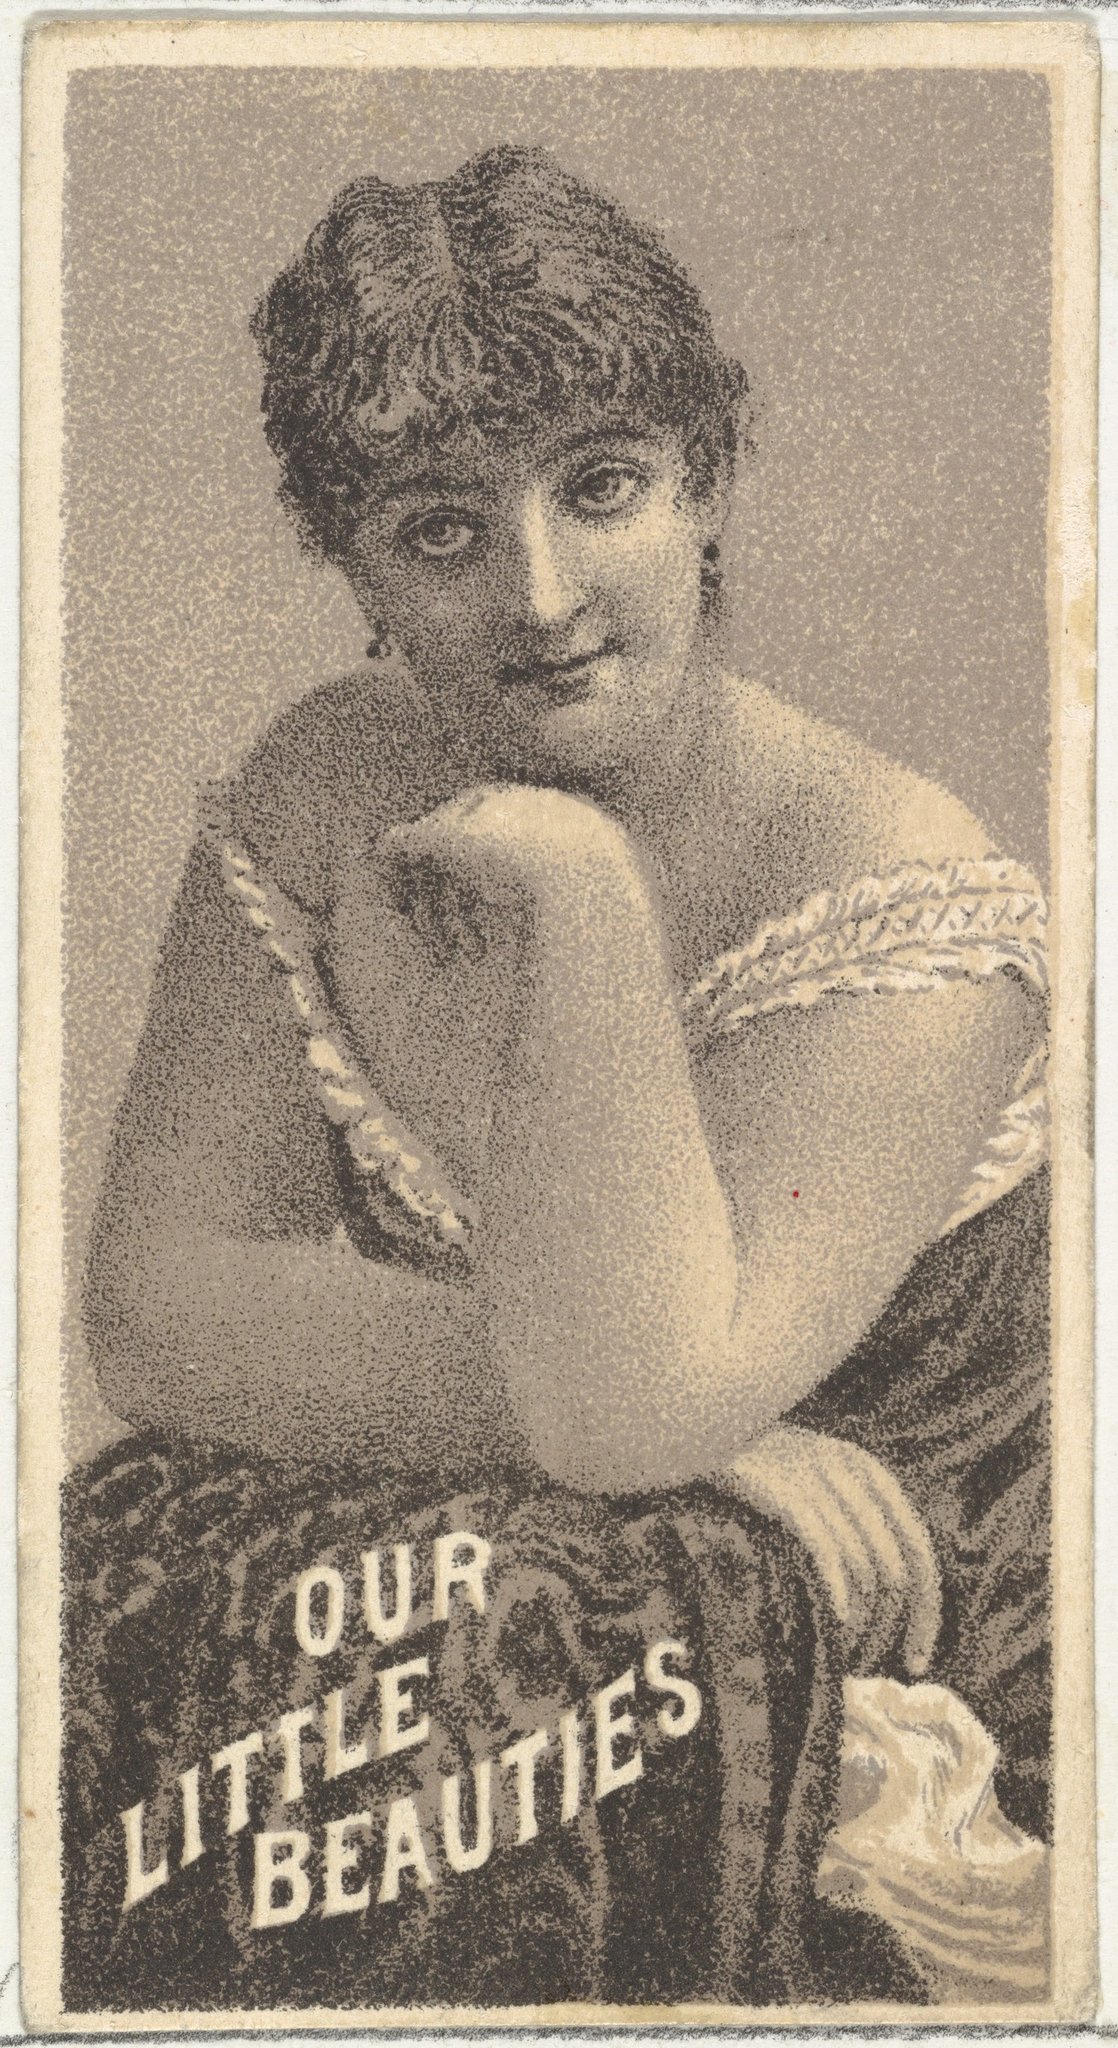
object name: print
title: From the Actresses series (N57) promoting Our Little Beauties Cigarettes for Allen & Ginter brand tobacco products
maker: allen & ginter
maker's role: publisher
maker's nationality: american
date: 1890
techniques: photolithograph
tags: portraits,women,actresses